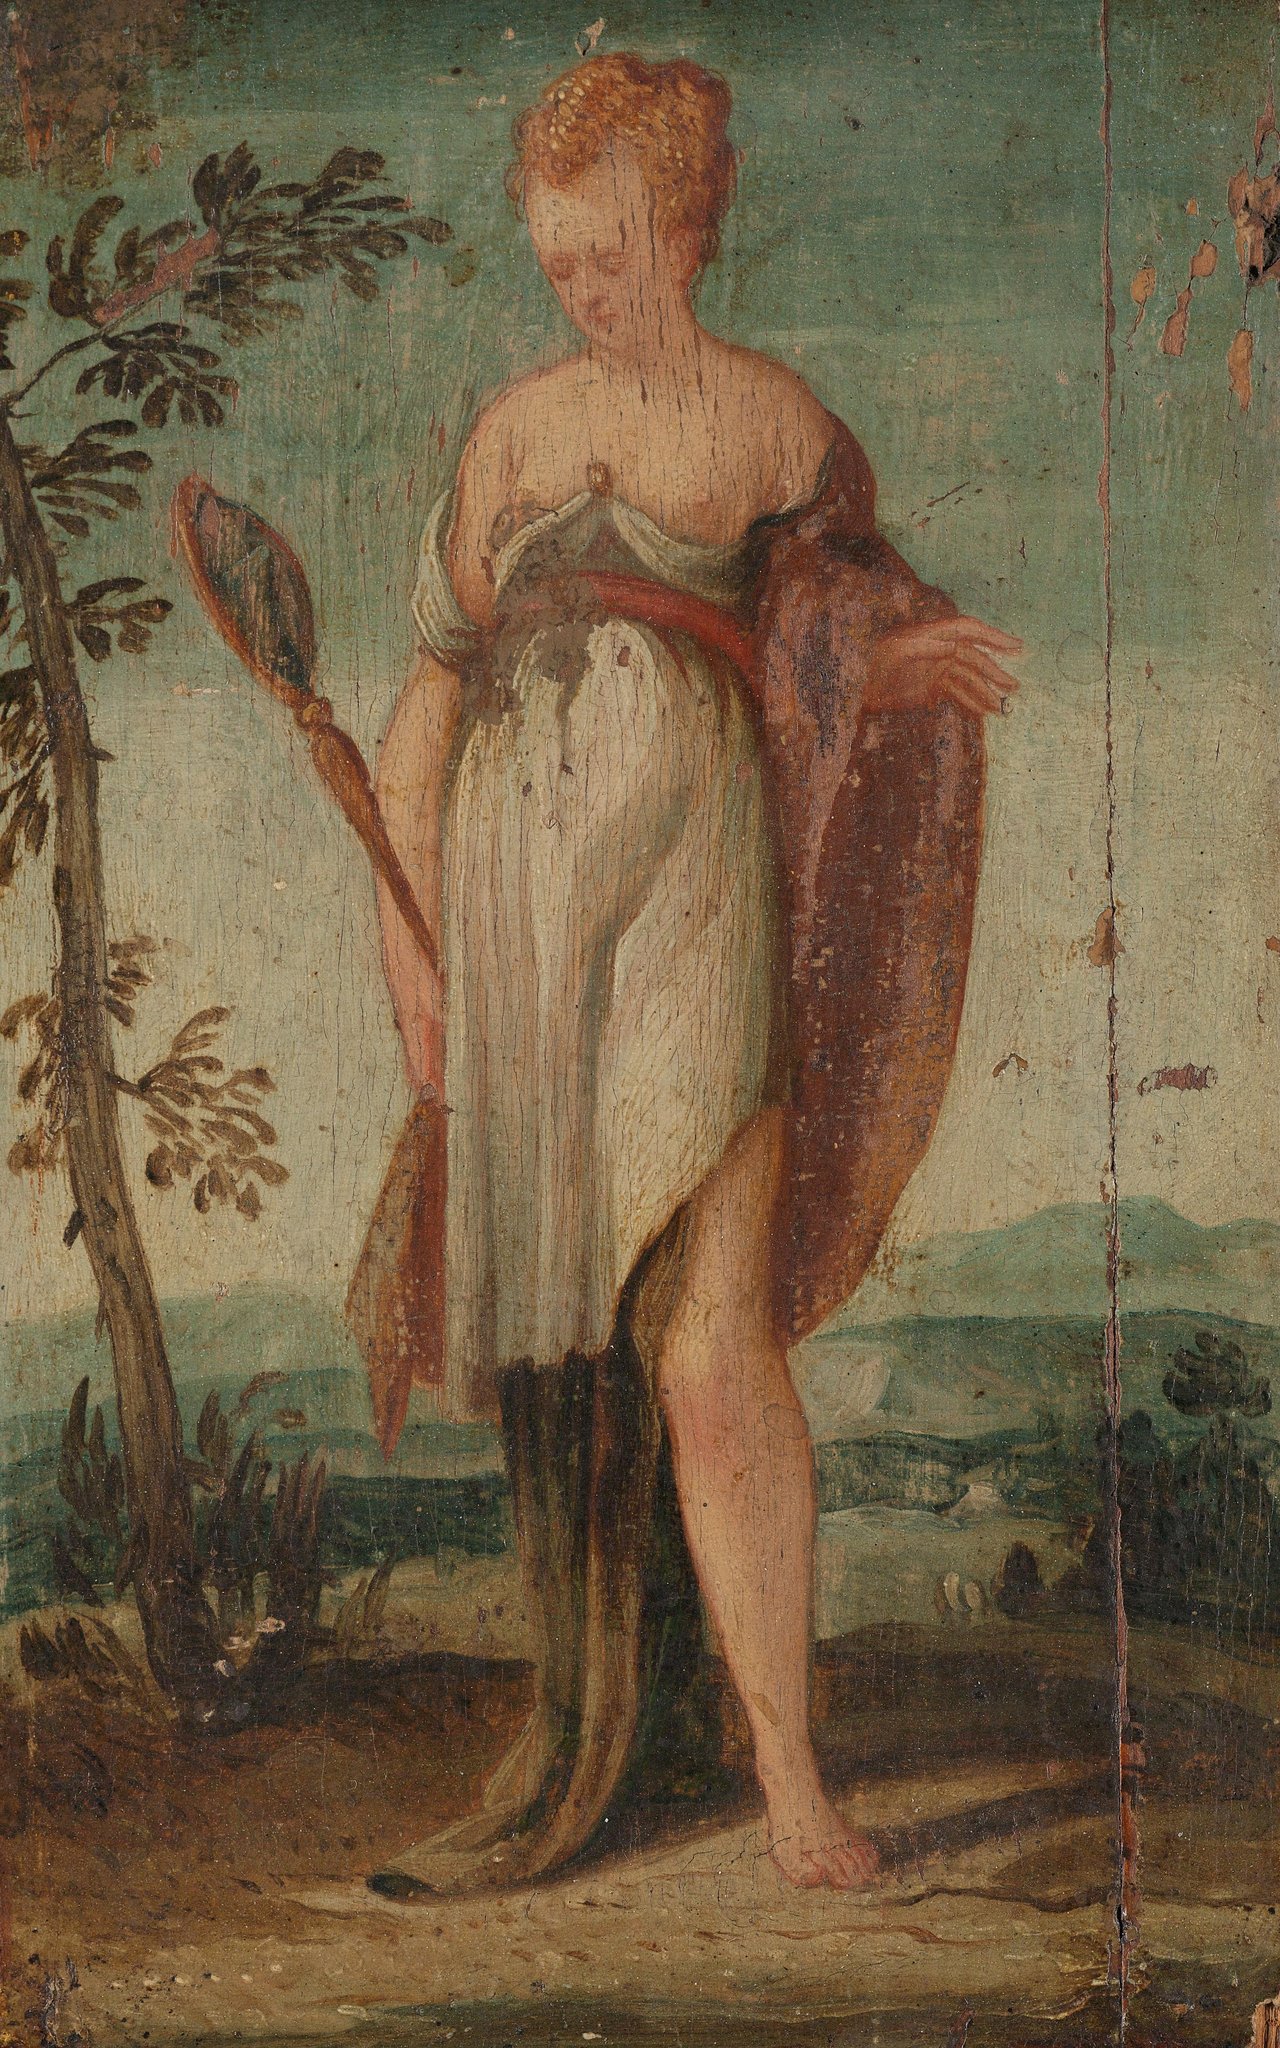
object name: painting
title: Woman with Mirror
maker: lambert sustris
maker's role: draughtsman, painter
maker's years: 1515-1591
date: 1540-1570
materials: oil, panel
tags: prudence, 'prudentia'; 'prudenza' (ripa) ~ one of the four cardinal virtues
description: Staande vrouw met ontbloot bovenlichaam en een spiegel in de rechterhand. De personificatie van Prudentia. Onderdeel van een reeks van vier allegorische vrouwenfiguren (SK-A-3424/3427).